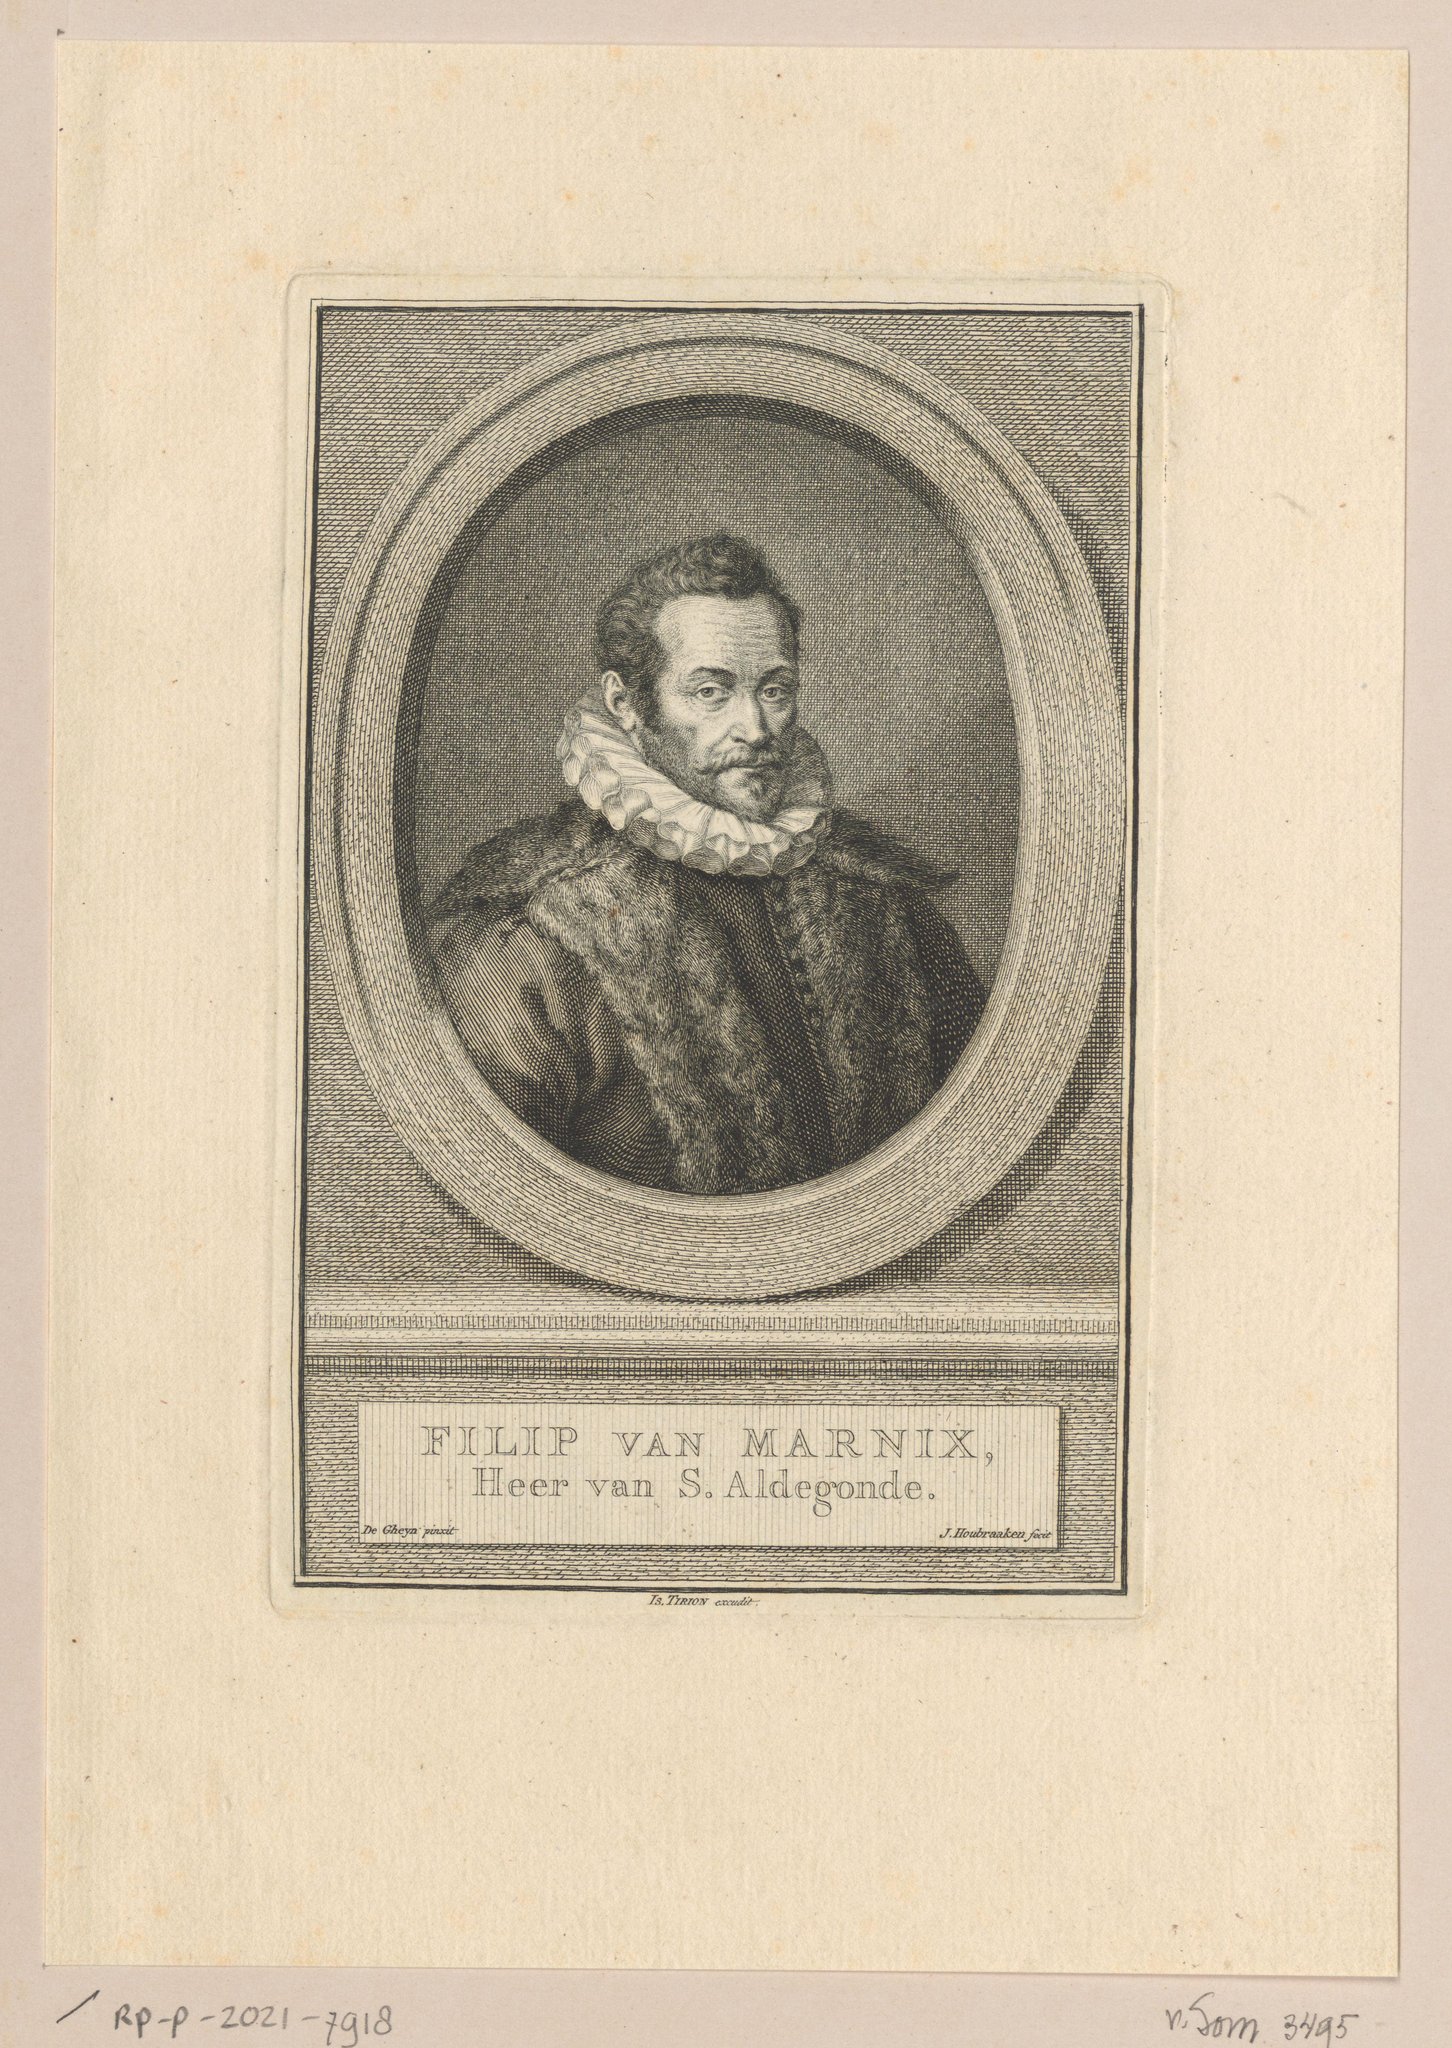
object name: print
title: Portret van Filips van Marnix, heer van Sint-Aldegonde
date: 1752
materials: paper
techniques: engraving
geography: amsterdam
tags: brussels, leiden, politician, filips van marnix van sint-aldegonde, ornament ~ medallion, historical persons, portrait of a writer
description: Prent waarschijnlijk uit: Wagenaar, Jan. Vaderlandsche historie, vervattende de geschiedenissen der nu Vereenigde Nederlanden, inzonderheid die van Holland (...). Amsterdam: Isaak Tirion, 1752, dl. 7. Latere staat is gebruikt in de editie uit 1792 van 'Vaderlandsche historie (...)'.